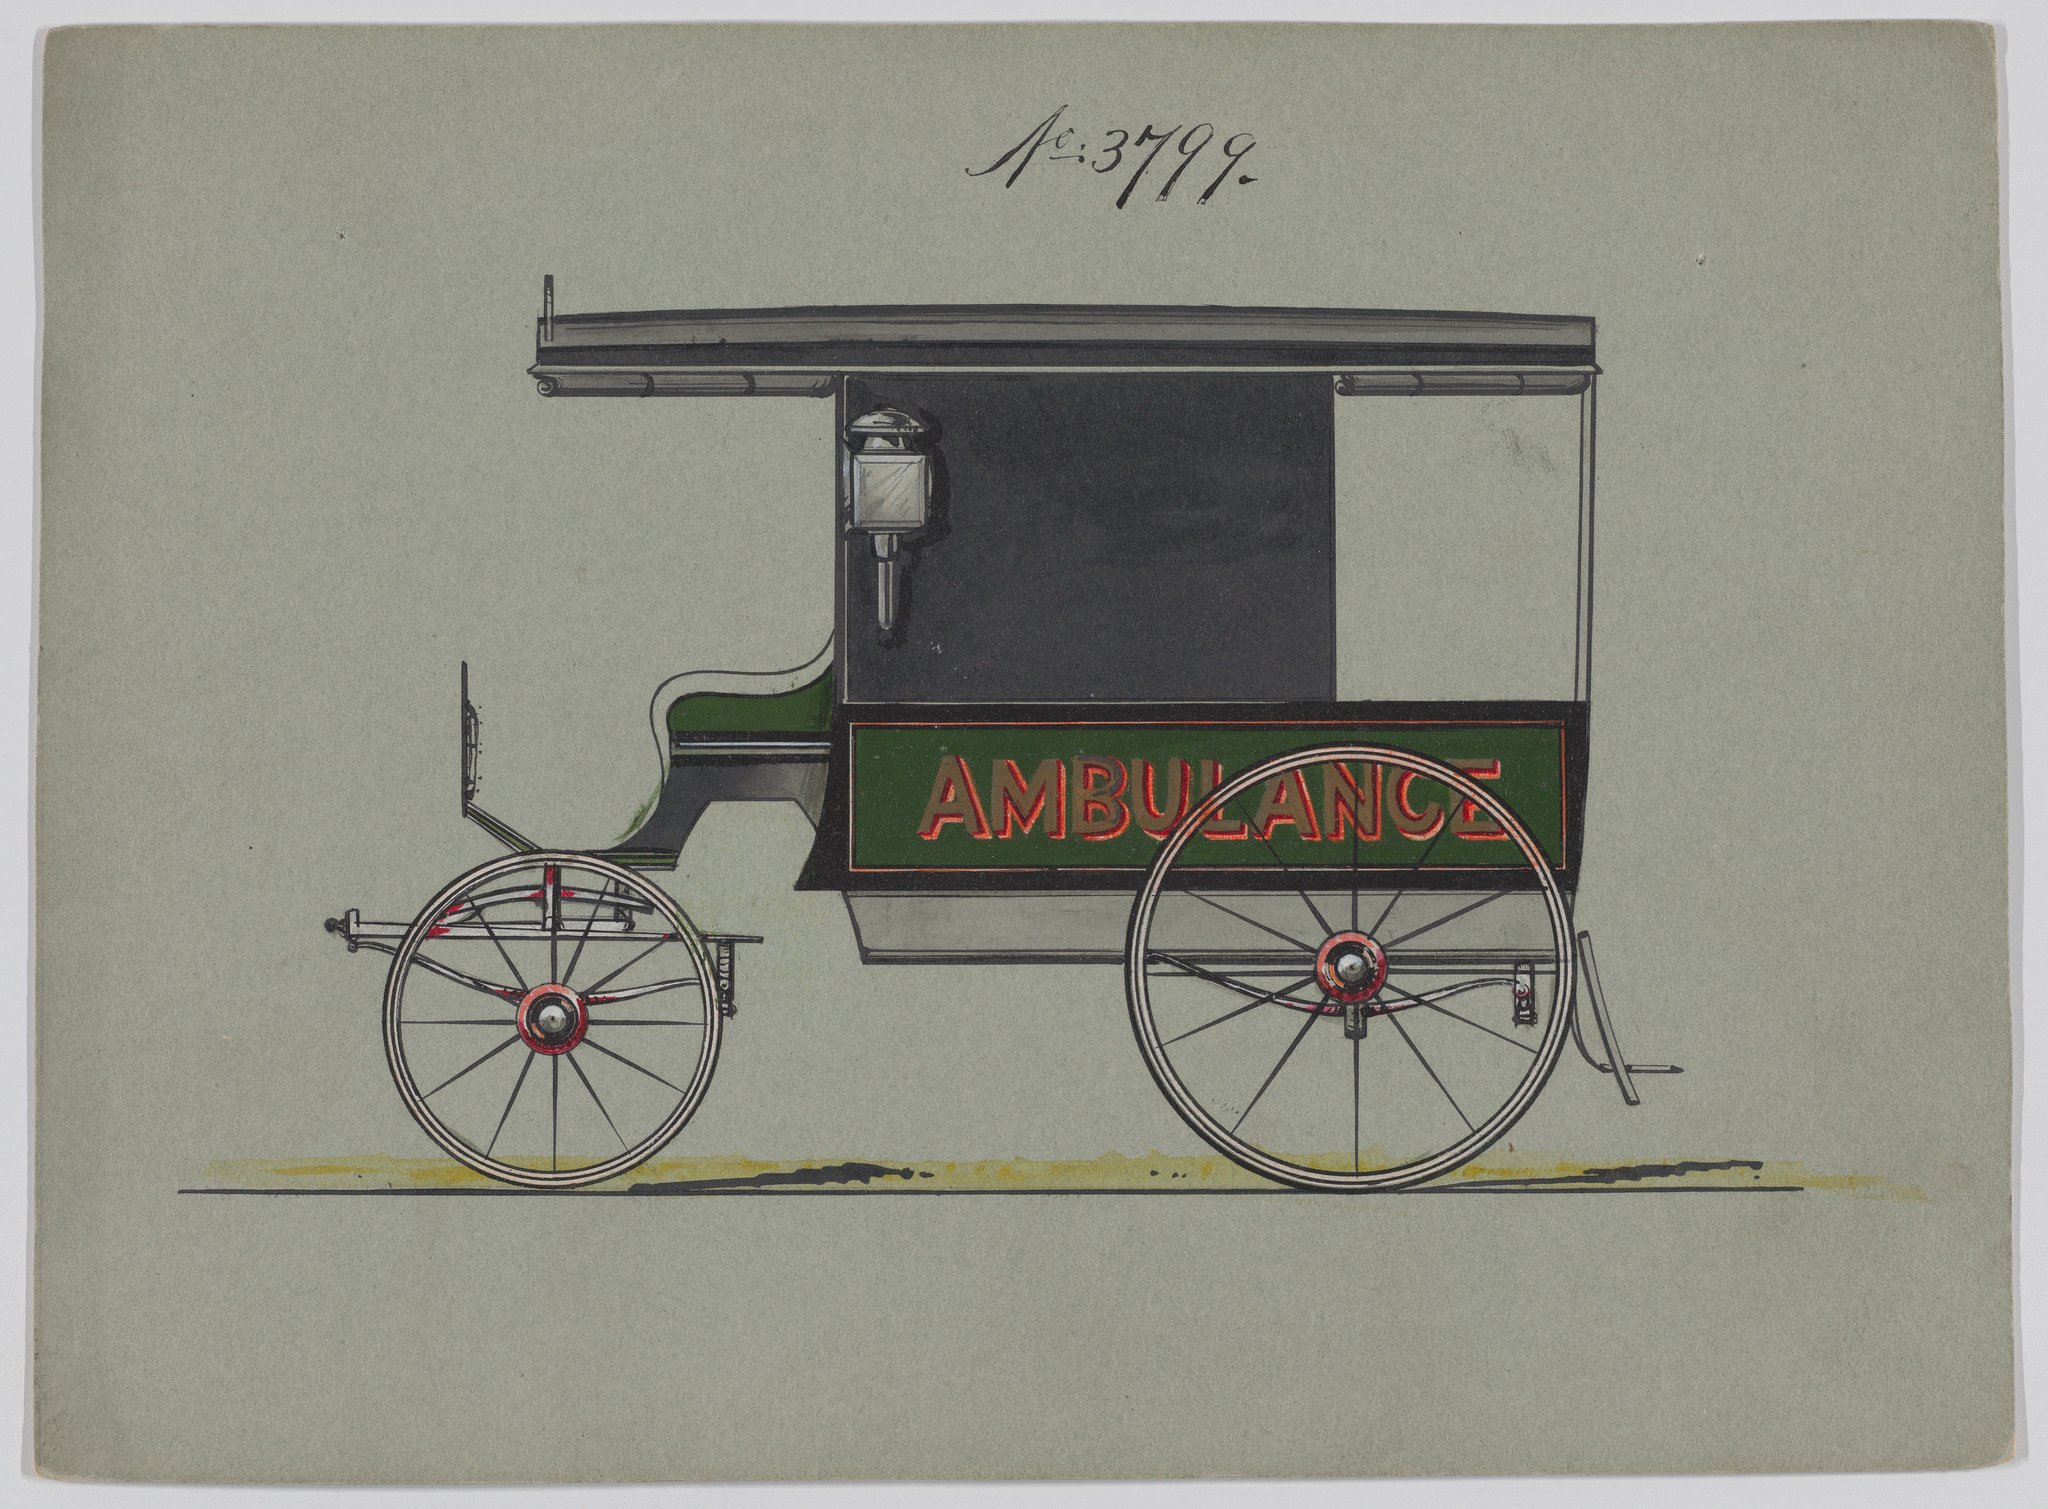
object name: drawing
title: Design for Omnibus or Wagonette, no. 3799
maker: brewster & co.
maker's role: manufacturer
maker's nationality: american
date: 1883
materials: gouache, gum arabic, ink, watercolor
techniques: pen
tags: carriages